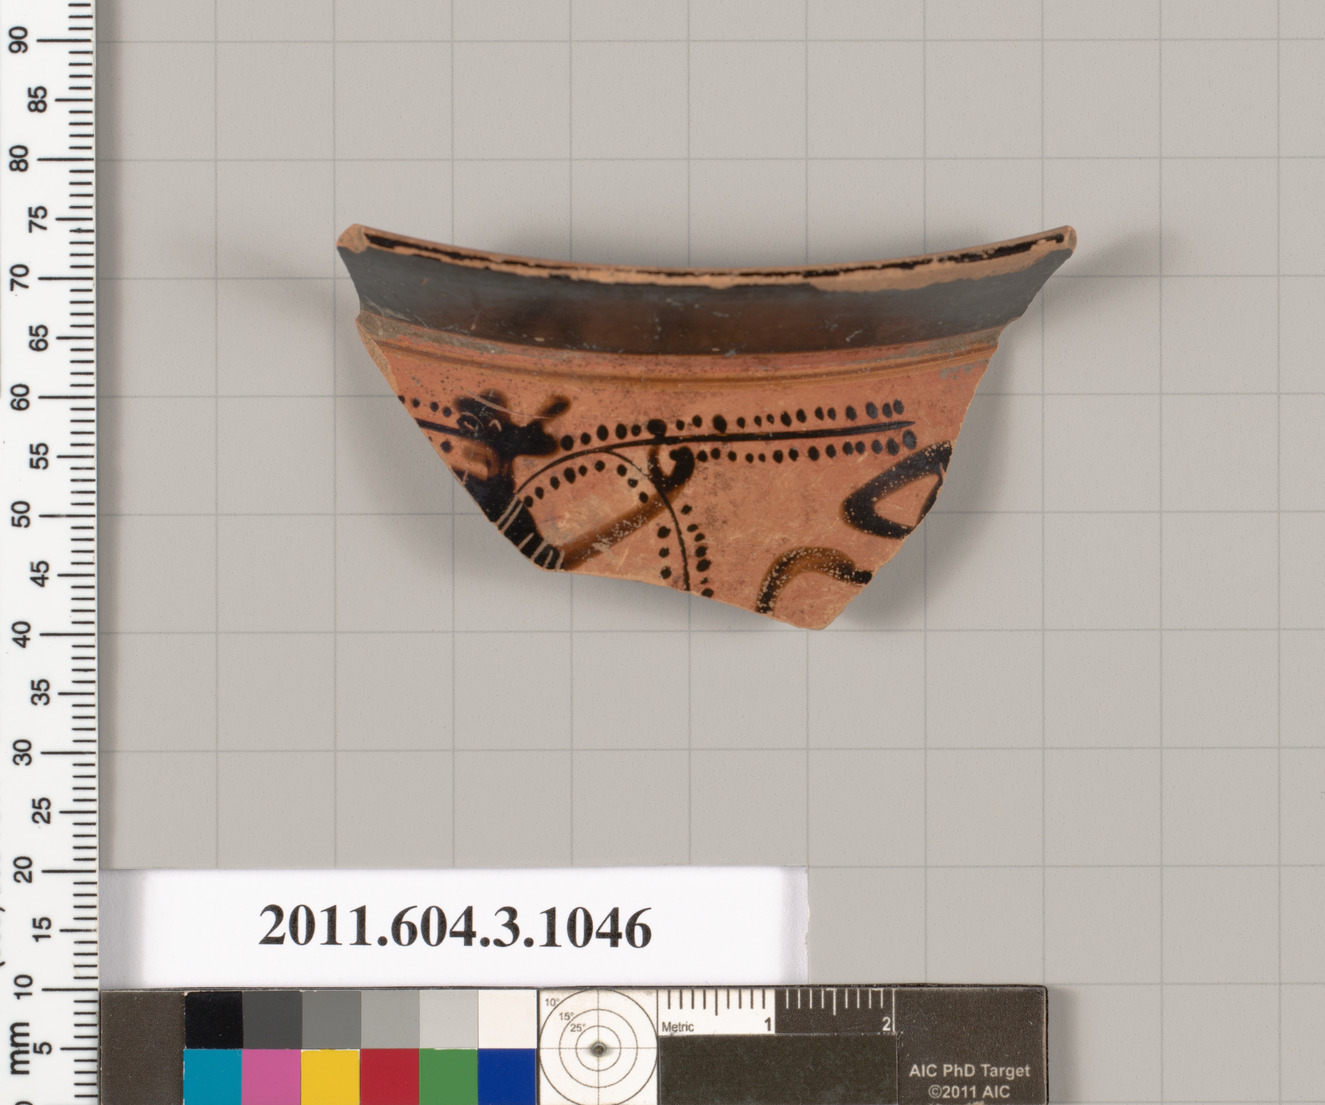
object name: mastoid fragment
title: Terracotta fragment of a mastoid (drinking cup with narrow base)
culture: greek, attic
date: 534-468 BCE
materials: terracotta